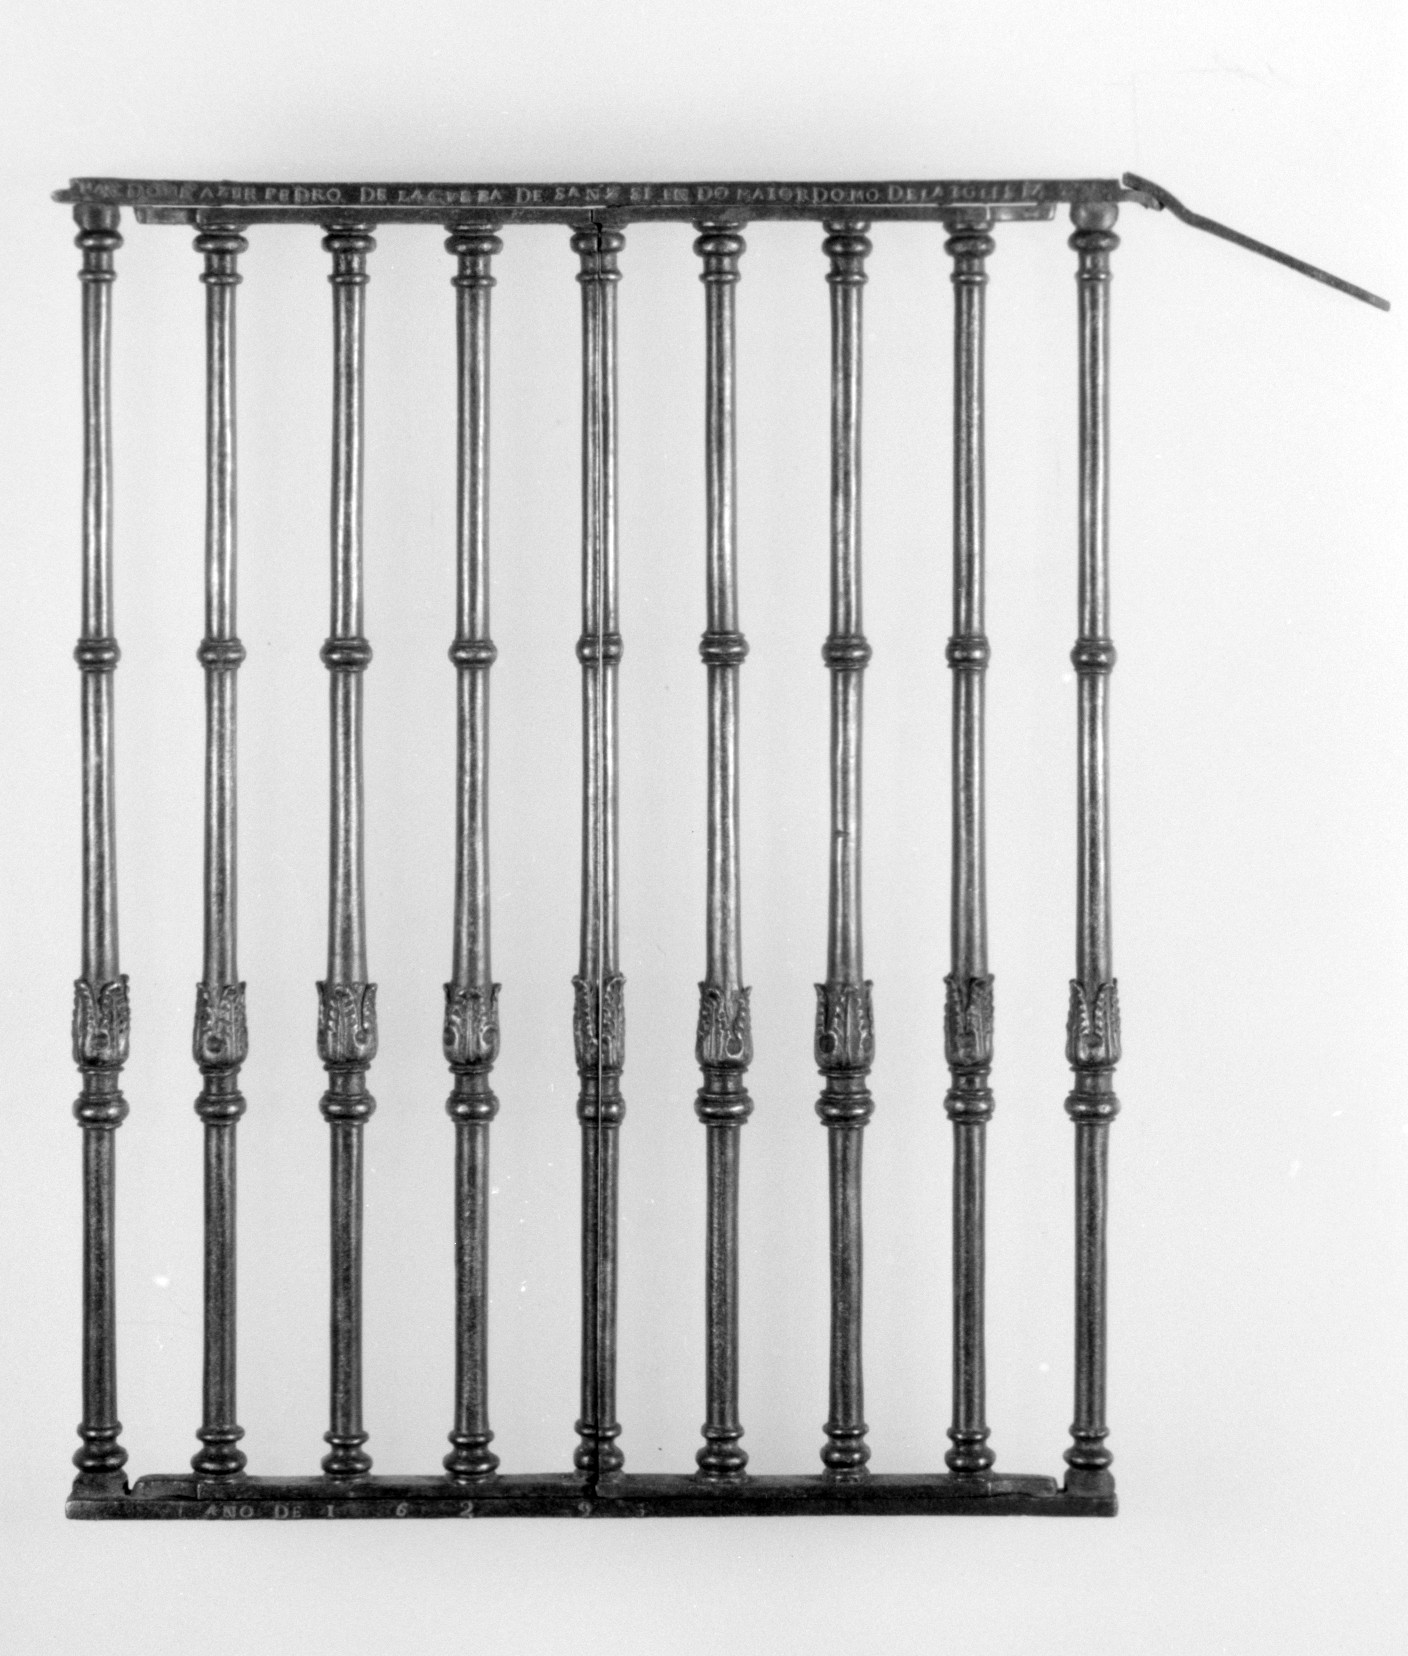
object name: confessional grille part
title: Part of a confessional grille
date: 1629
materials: iron